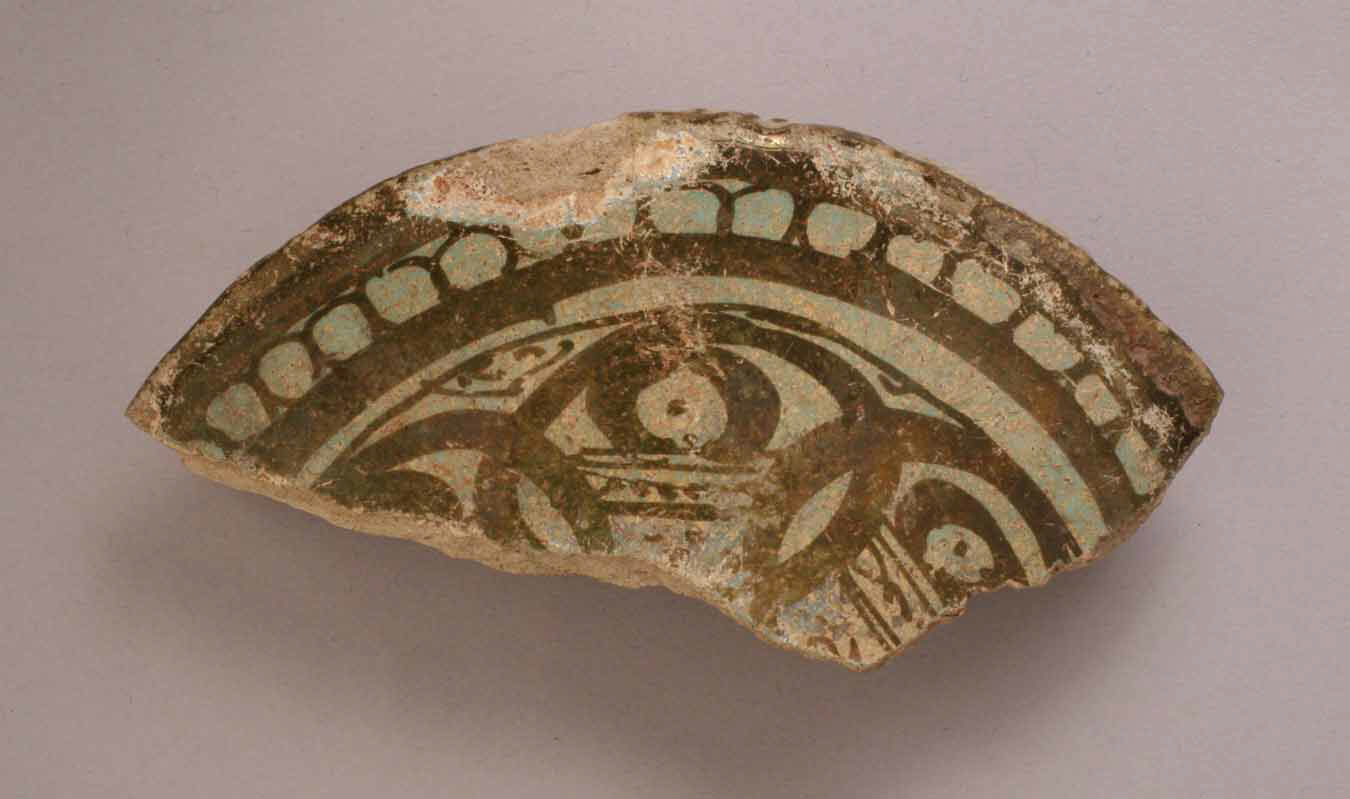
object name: fragment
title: Ceramic Fragment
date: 1001-1100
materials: earthenware, tin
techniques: enamel, luster painting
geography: syria